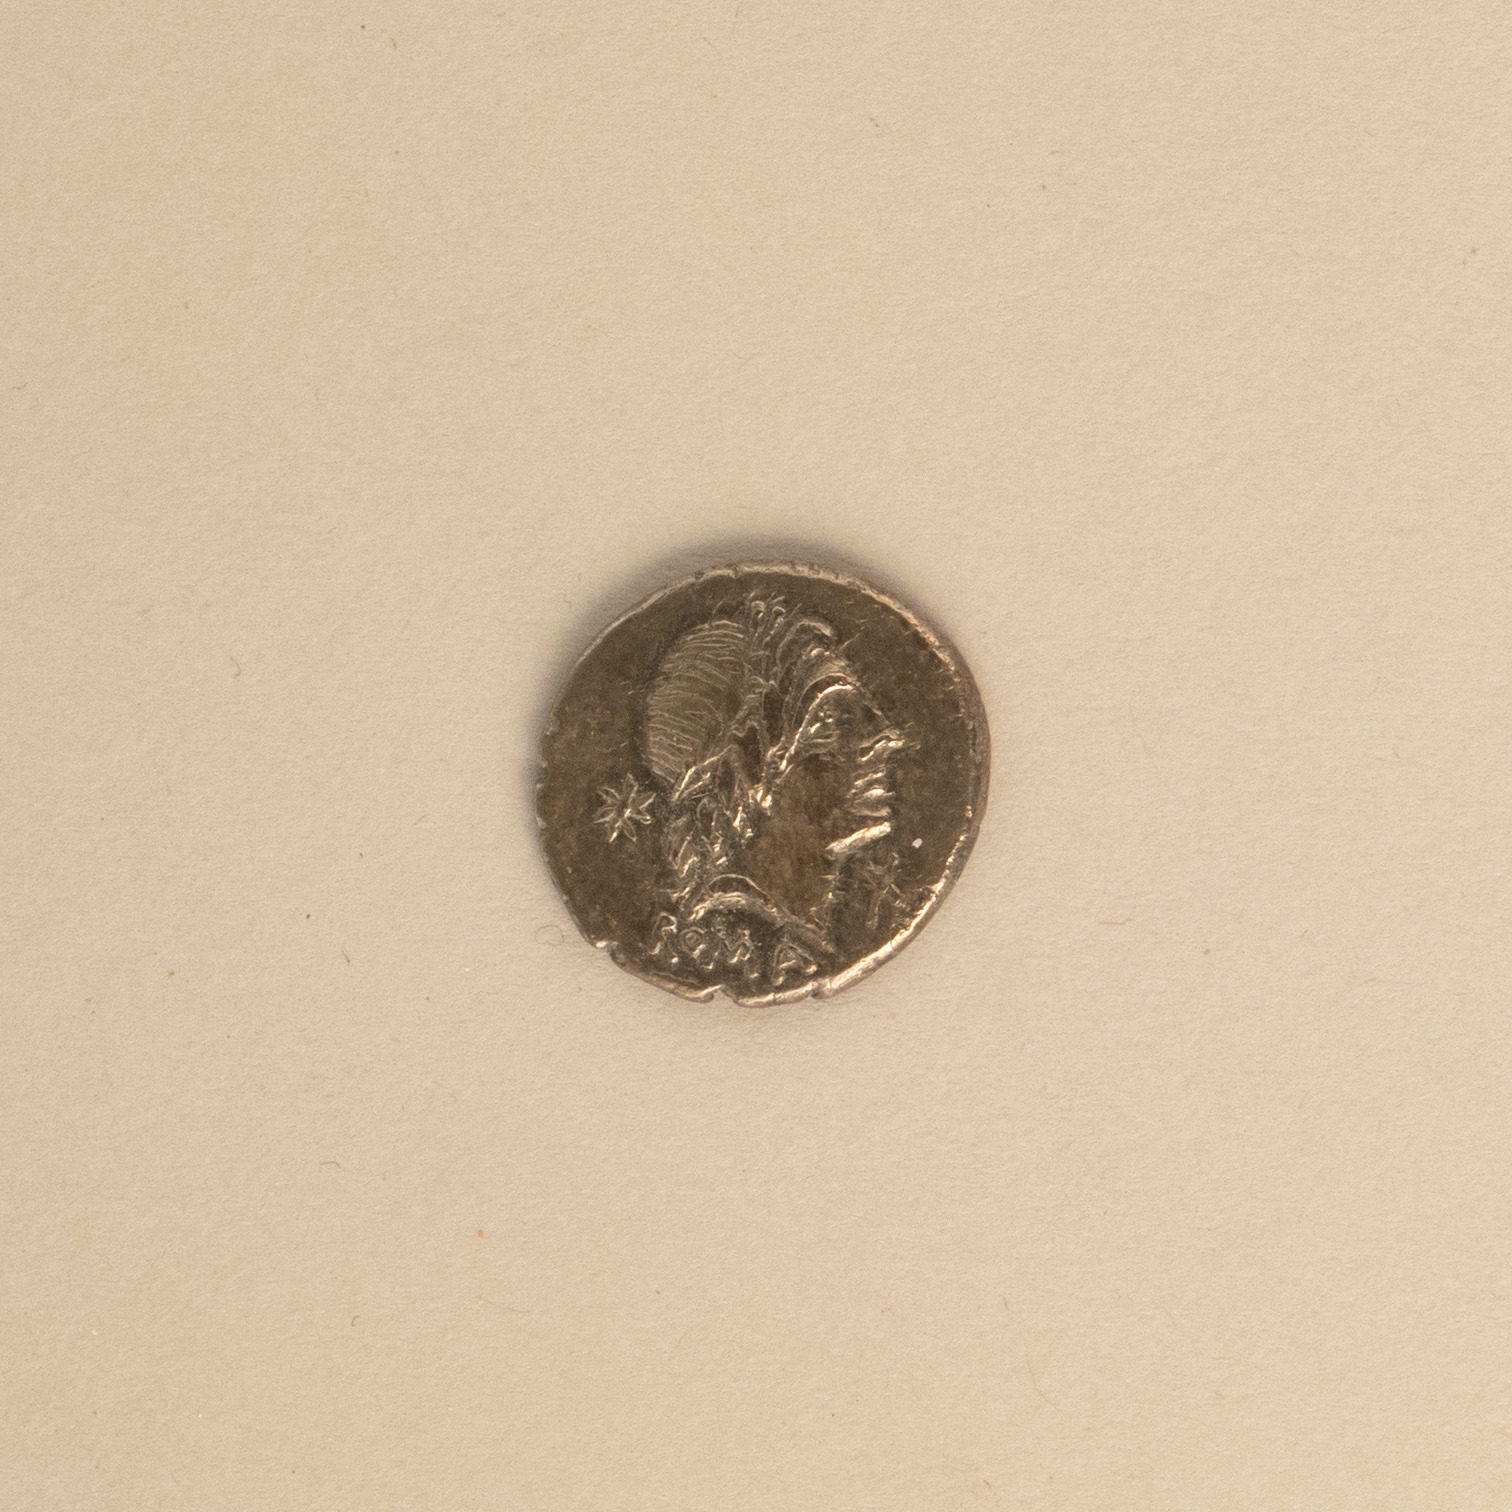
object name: denarius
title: Silver denarius of Postumius Albinus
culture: roman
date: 96 BCE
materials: silver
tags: human figures,profiles,apollo,horses,coins